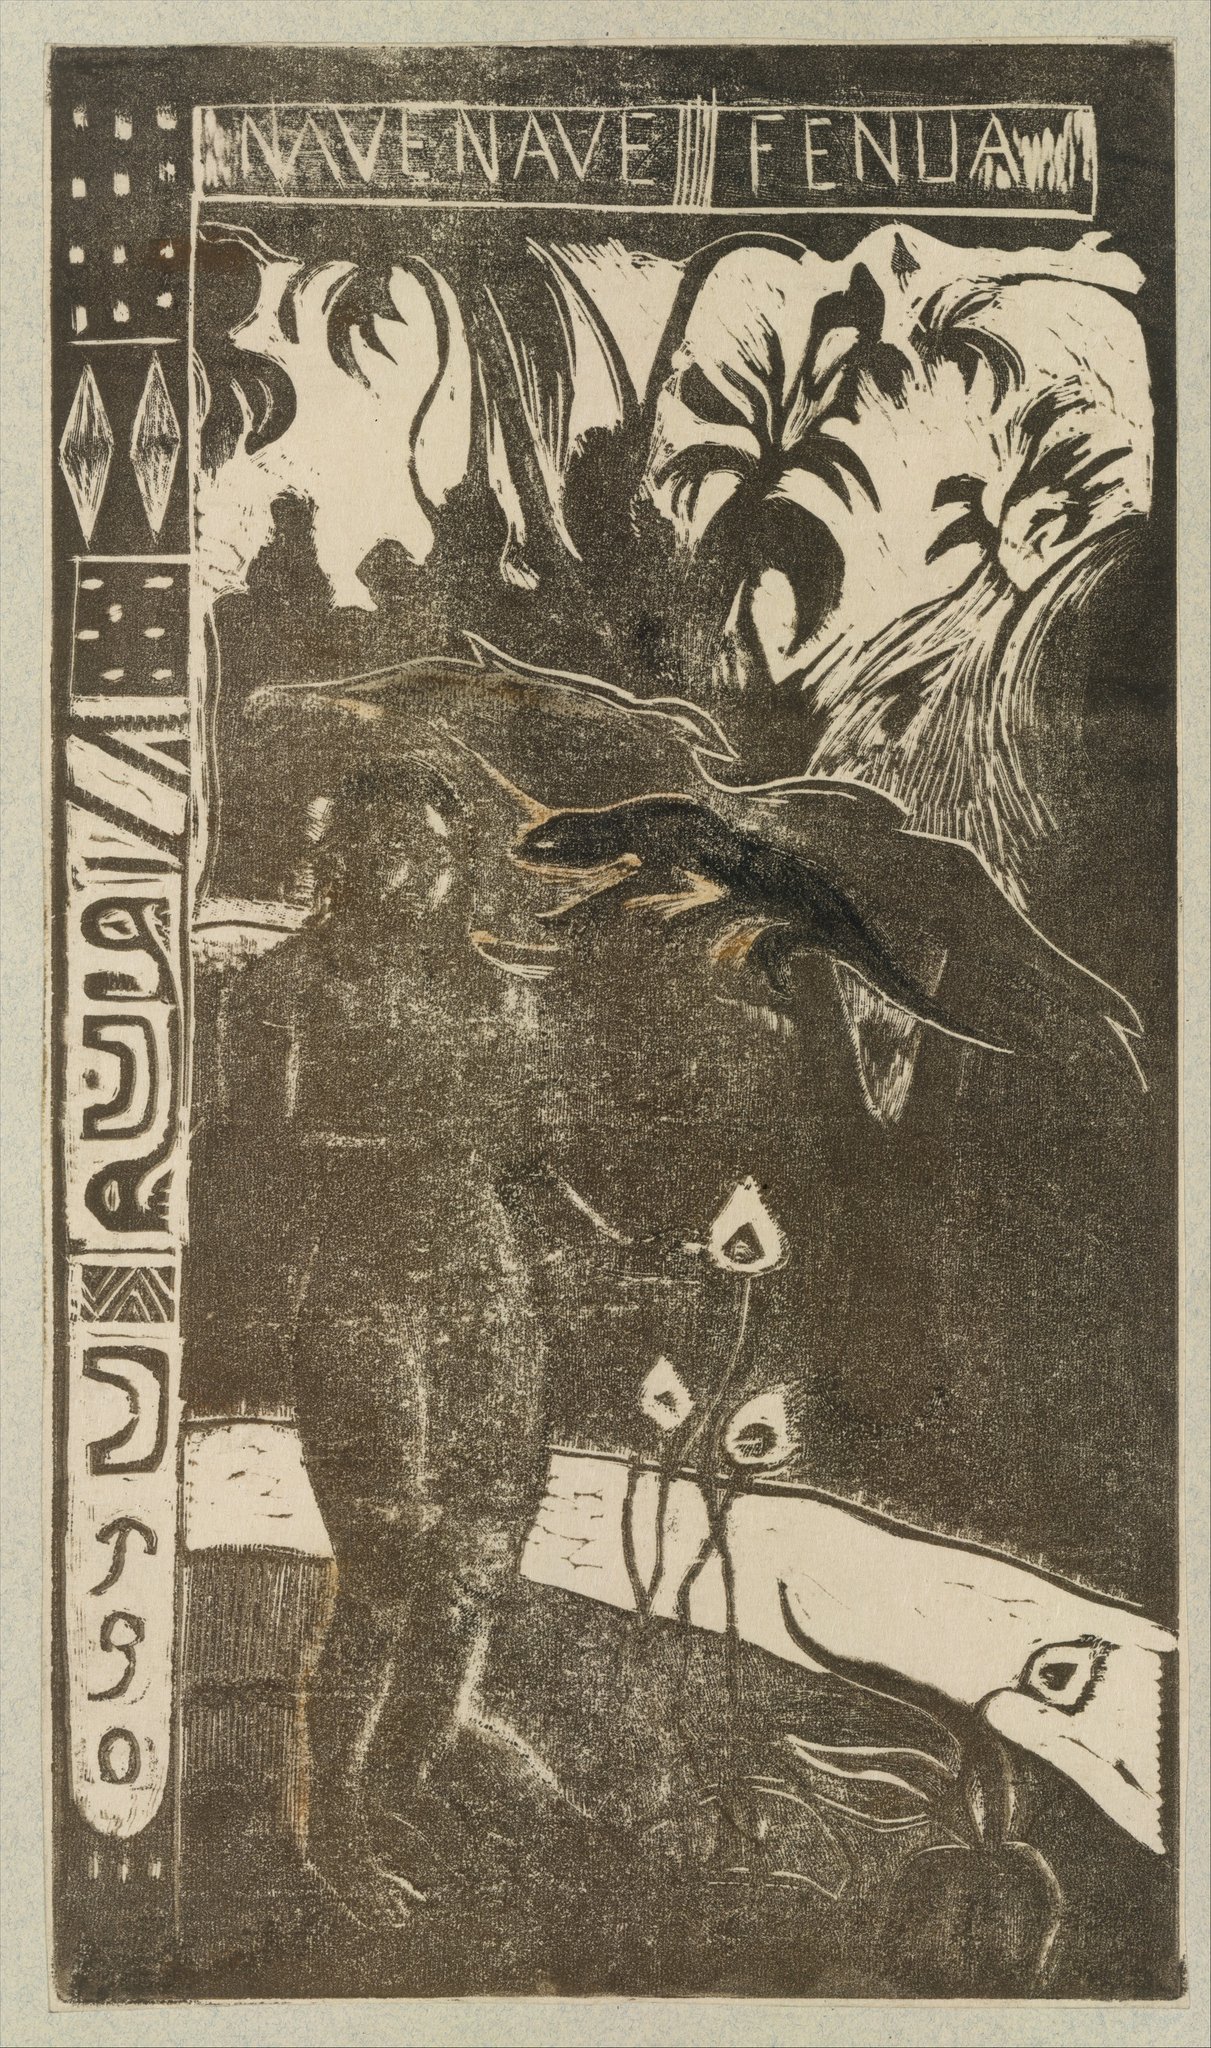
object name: print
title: Delightful Land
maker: paul gauguin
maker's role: artist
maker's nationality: french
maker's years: 1848-1903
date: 1893-1894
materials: paper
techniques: printing, woodcut